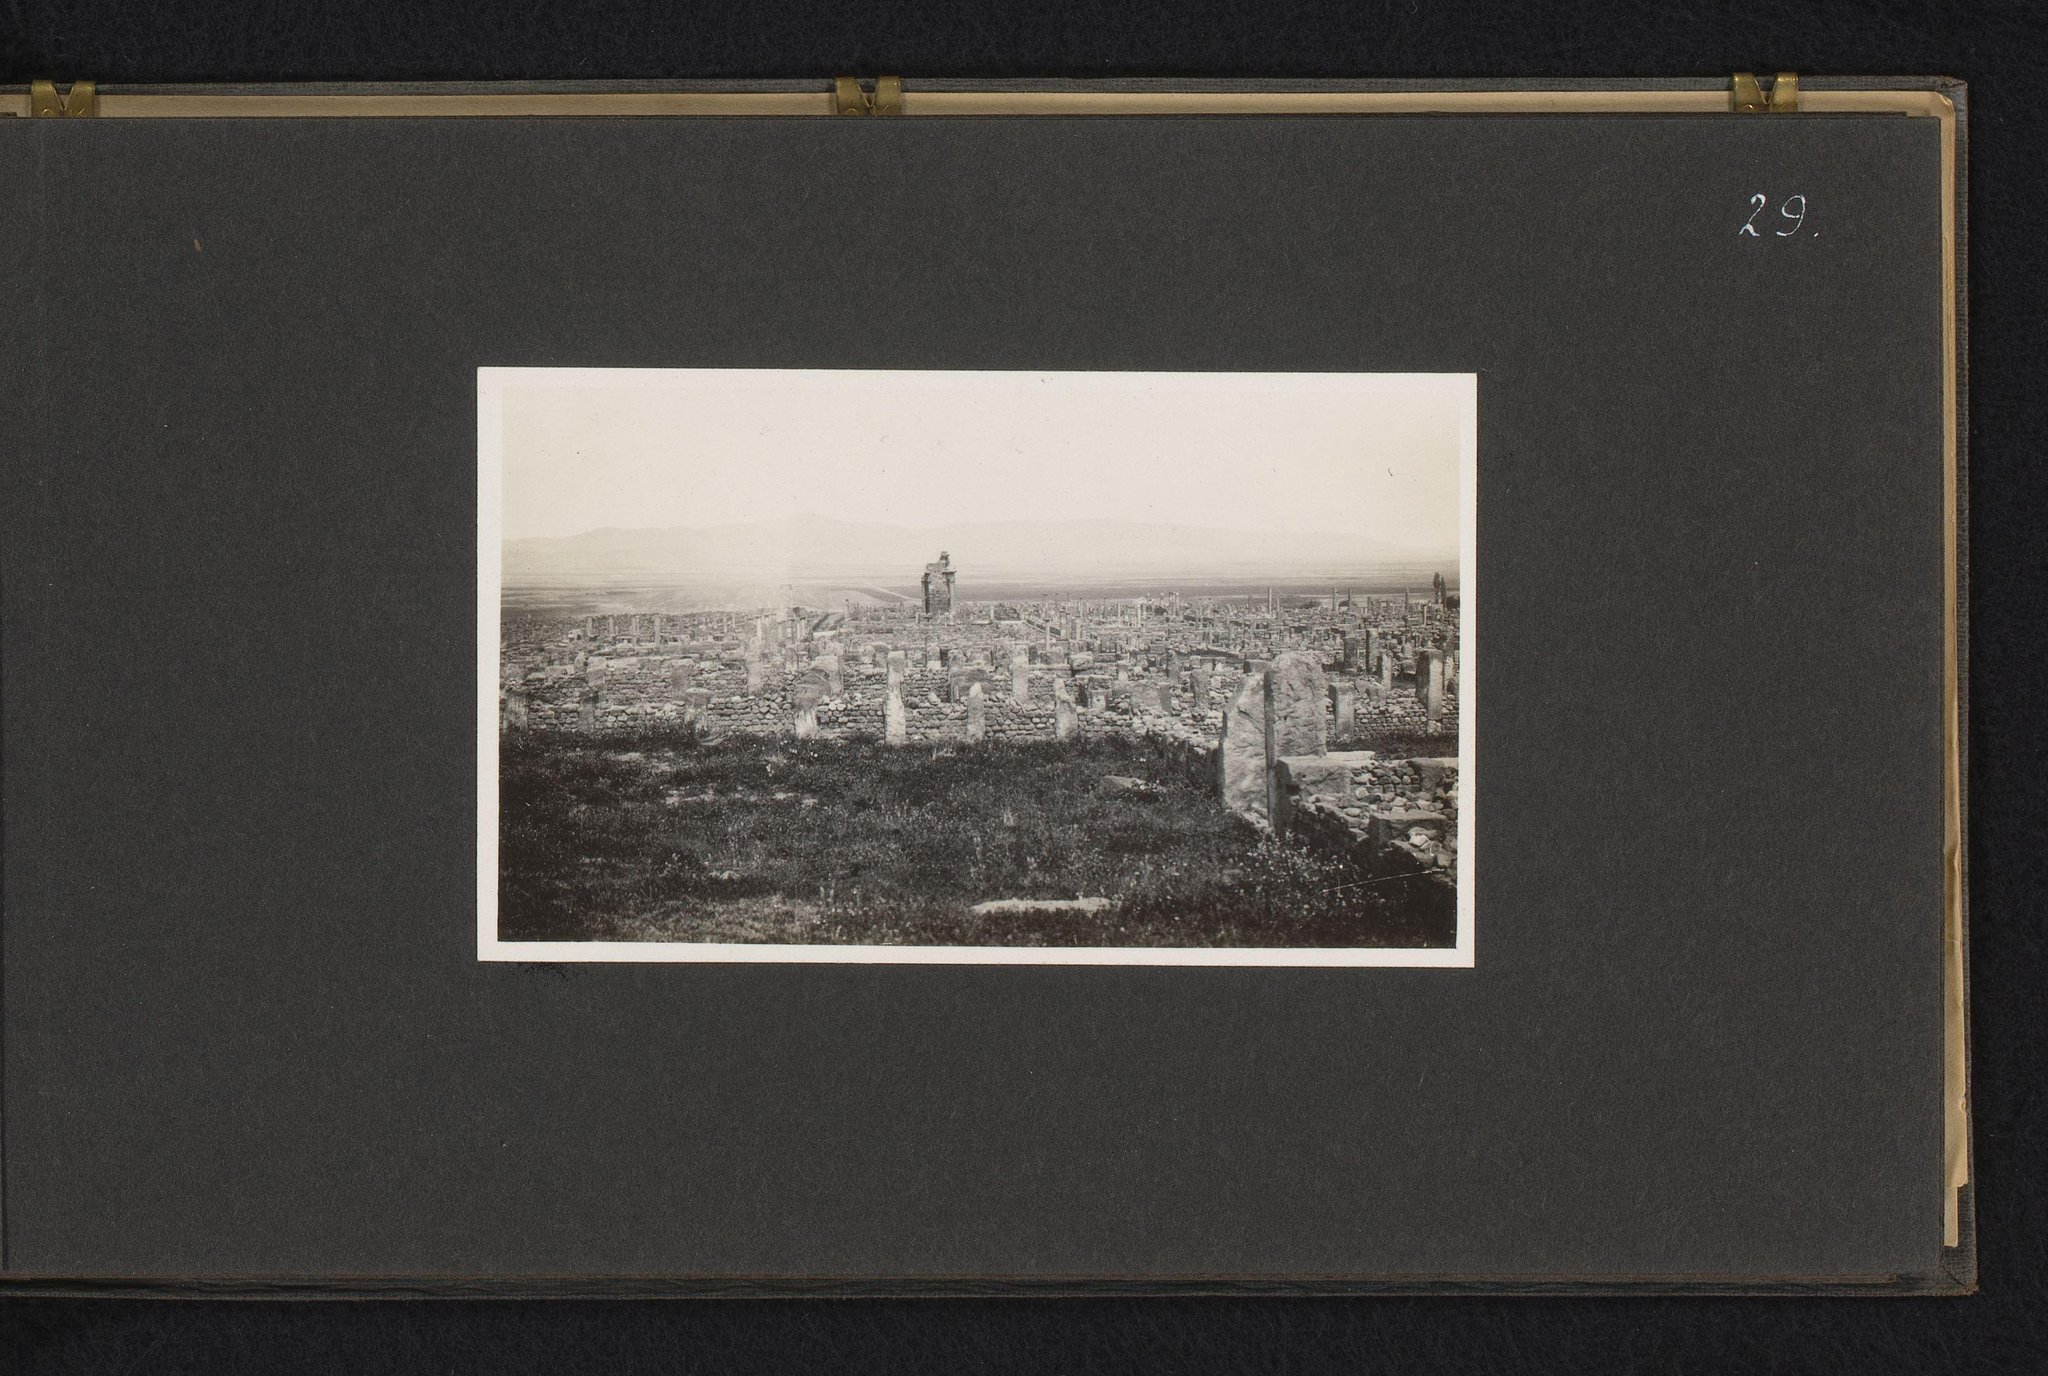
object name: photograph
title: Ruïnes van Timgad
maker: a.g.a. van eelde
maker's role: engineer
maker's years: 1862-1950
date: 1927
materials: paper, photographic support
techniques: gelatin silver print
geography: timgad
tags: landscape with ruins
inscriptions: number: ‘29.’